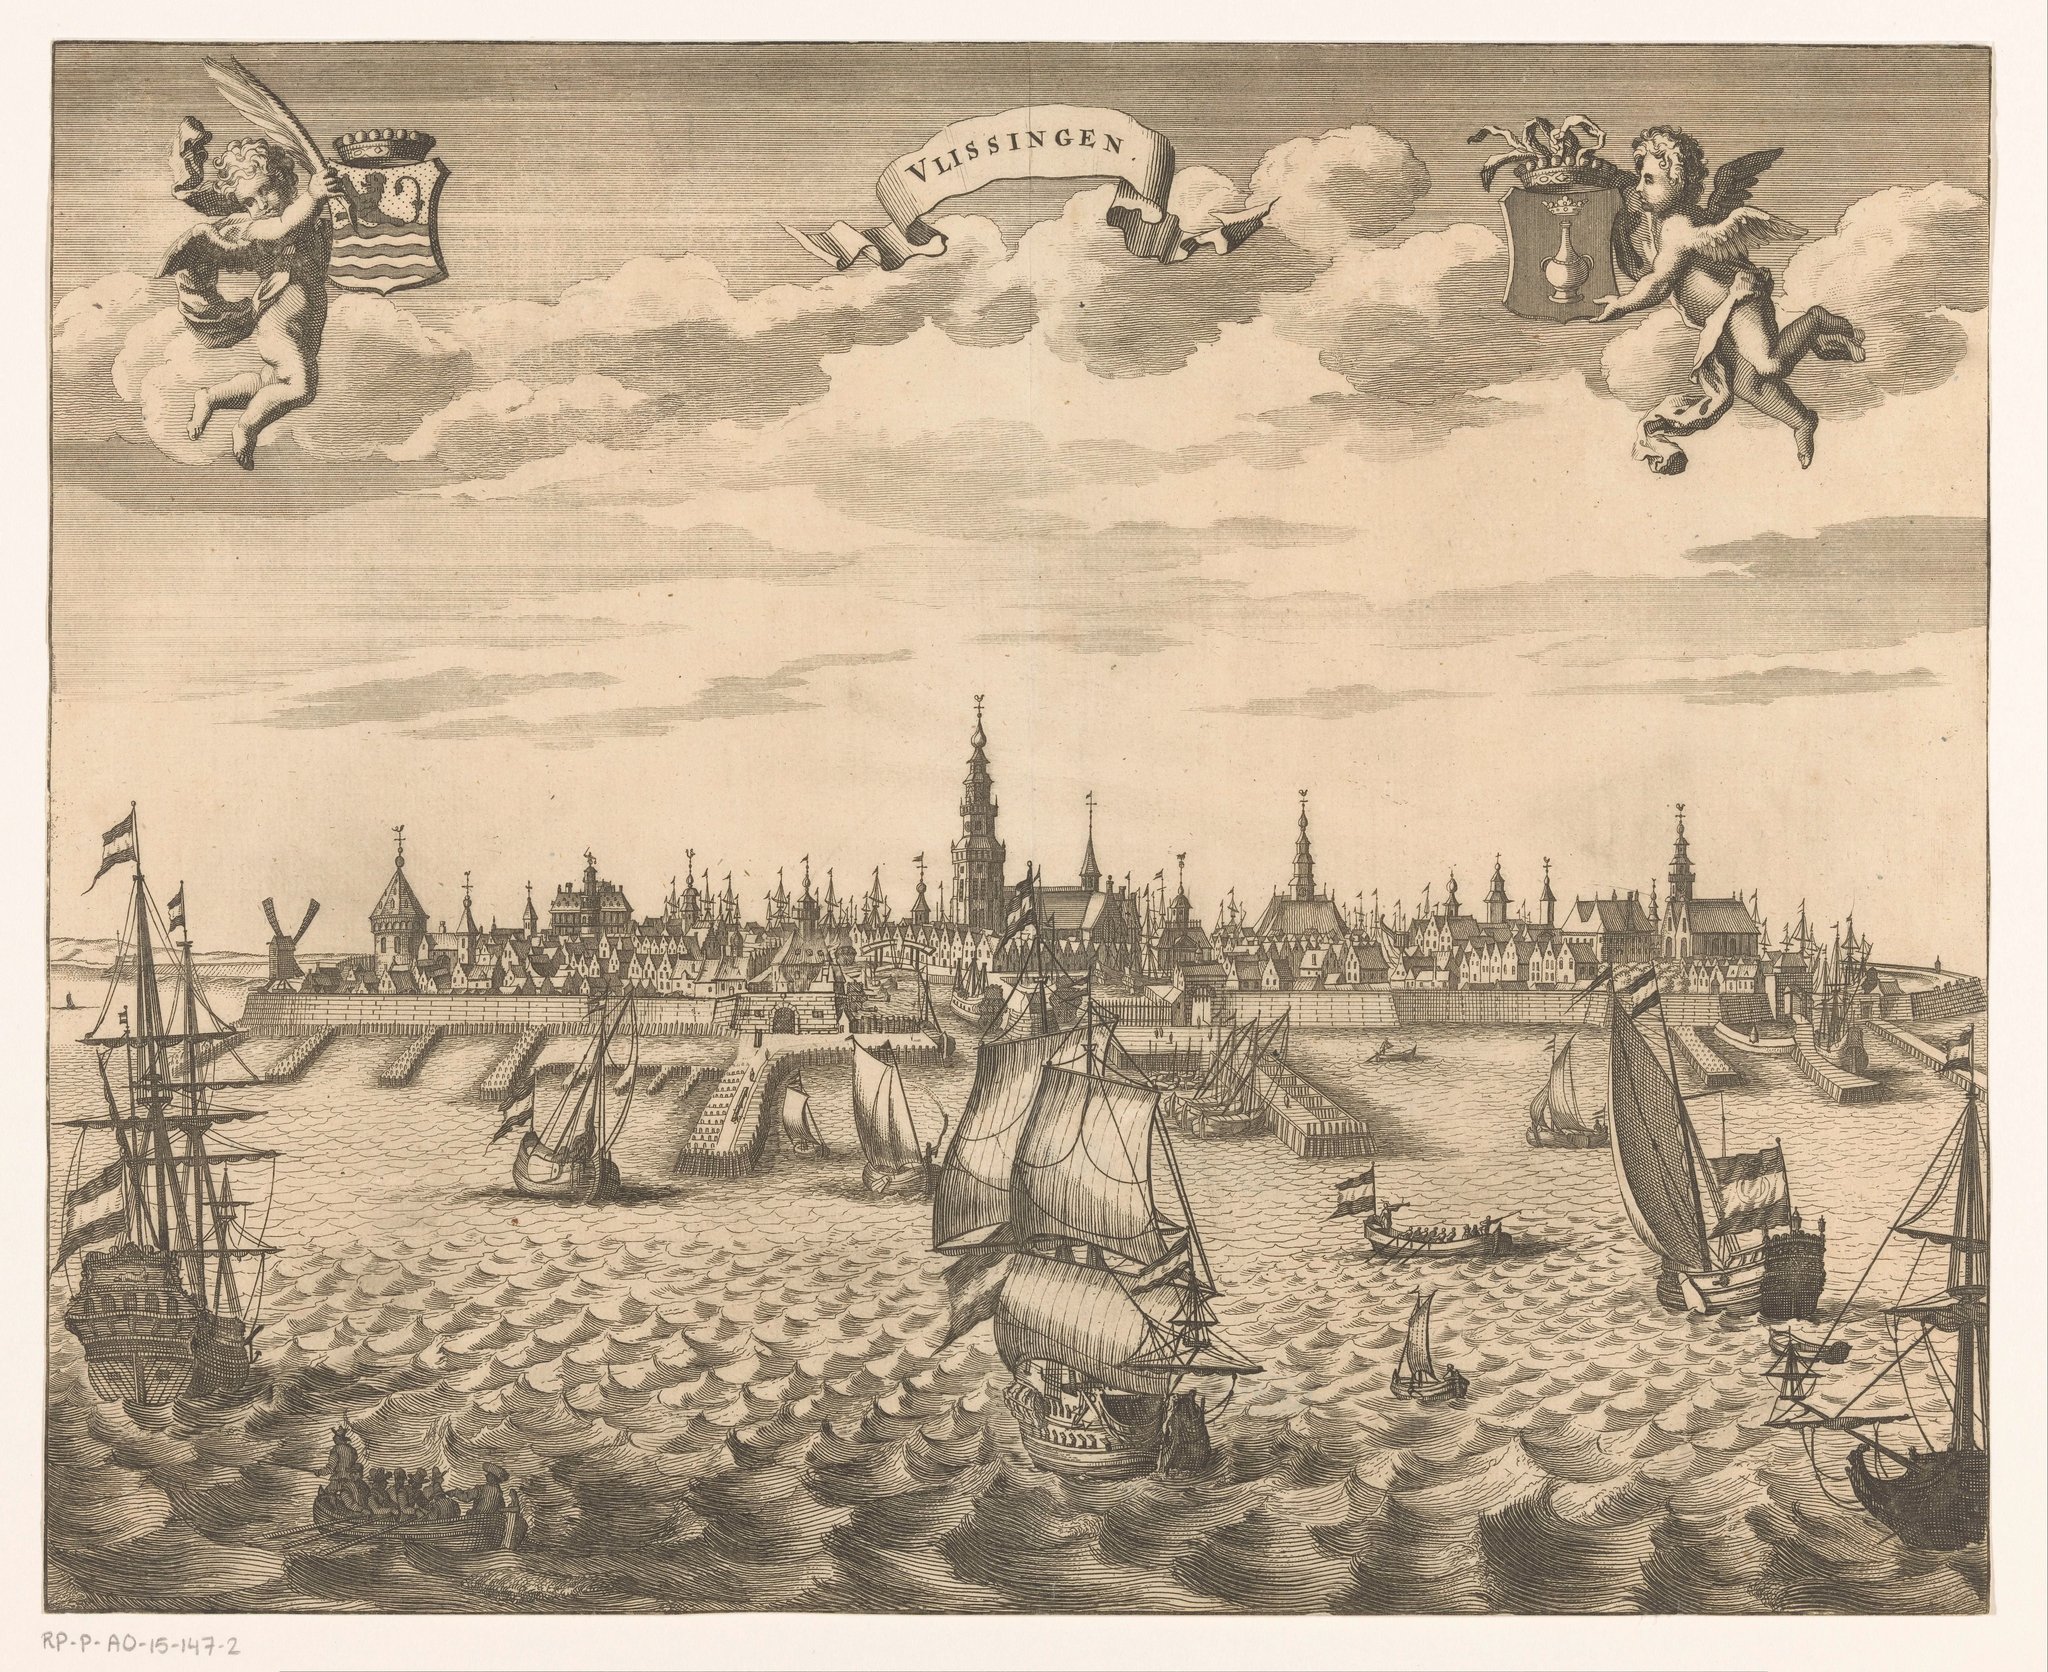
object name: book illustration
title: Gezicht op Vlissingen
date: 1696-1728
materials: paper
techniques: engraving, etching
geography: middelburg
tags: harbour, coat of arms (as symbol of the state, etc.) (+ city; municipal), coat of arms (as symbol of the state, etc.) (+ province; provincial), prospect of city, town panorama, silhouette of city, flushing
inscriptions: collector's mark: Lugt 2228, collector's mark: Lugt 195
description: Doordat deze prent binnen de plaatrand is afgesneden kan de staat niet bepaald worden. Eerste bekende staat van prent (rechtsboven genummerd) ook gebruikt in: Smallegange, Mattheus. Nieuwe Cronyk van Zeeland (…). Middelburg en Amsterdam: Johannes Meertens en Abraham van Someren, 1696. Tweede bekende staat van prent (geen nummering rechtsboven) ook gebruikt in sommige exemplaren van: Aa, Pieter van der. La galerie agreable du monde (...). 66 delen. Leiden: Pieter van der Aa, 1728, dl. 21.